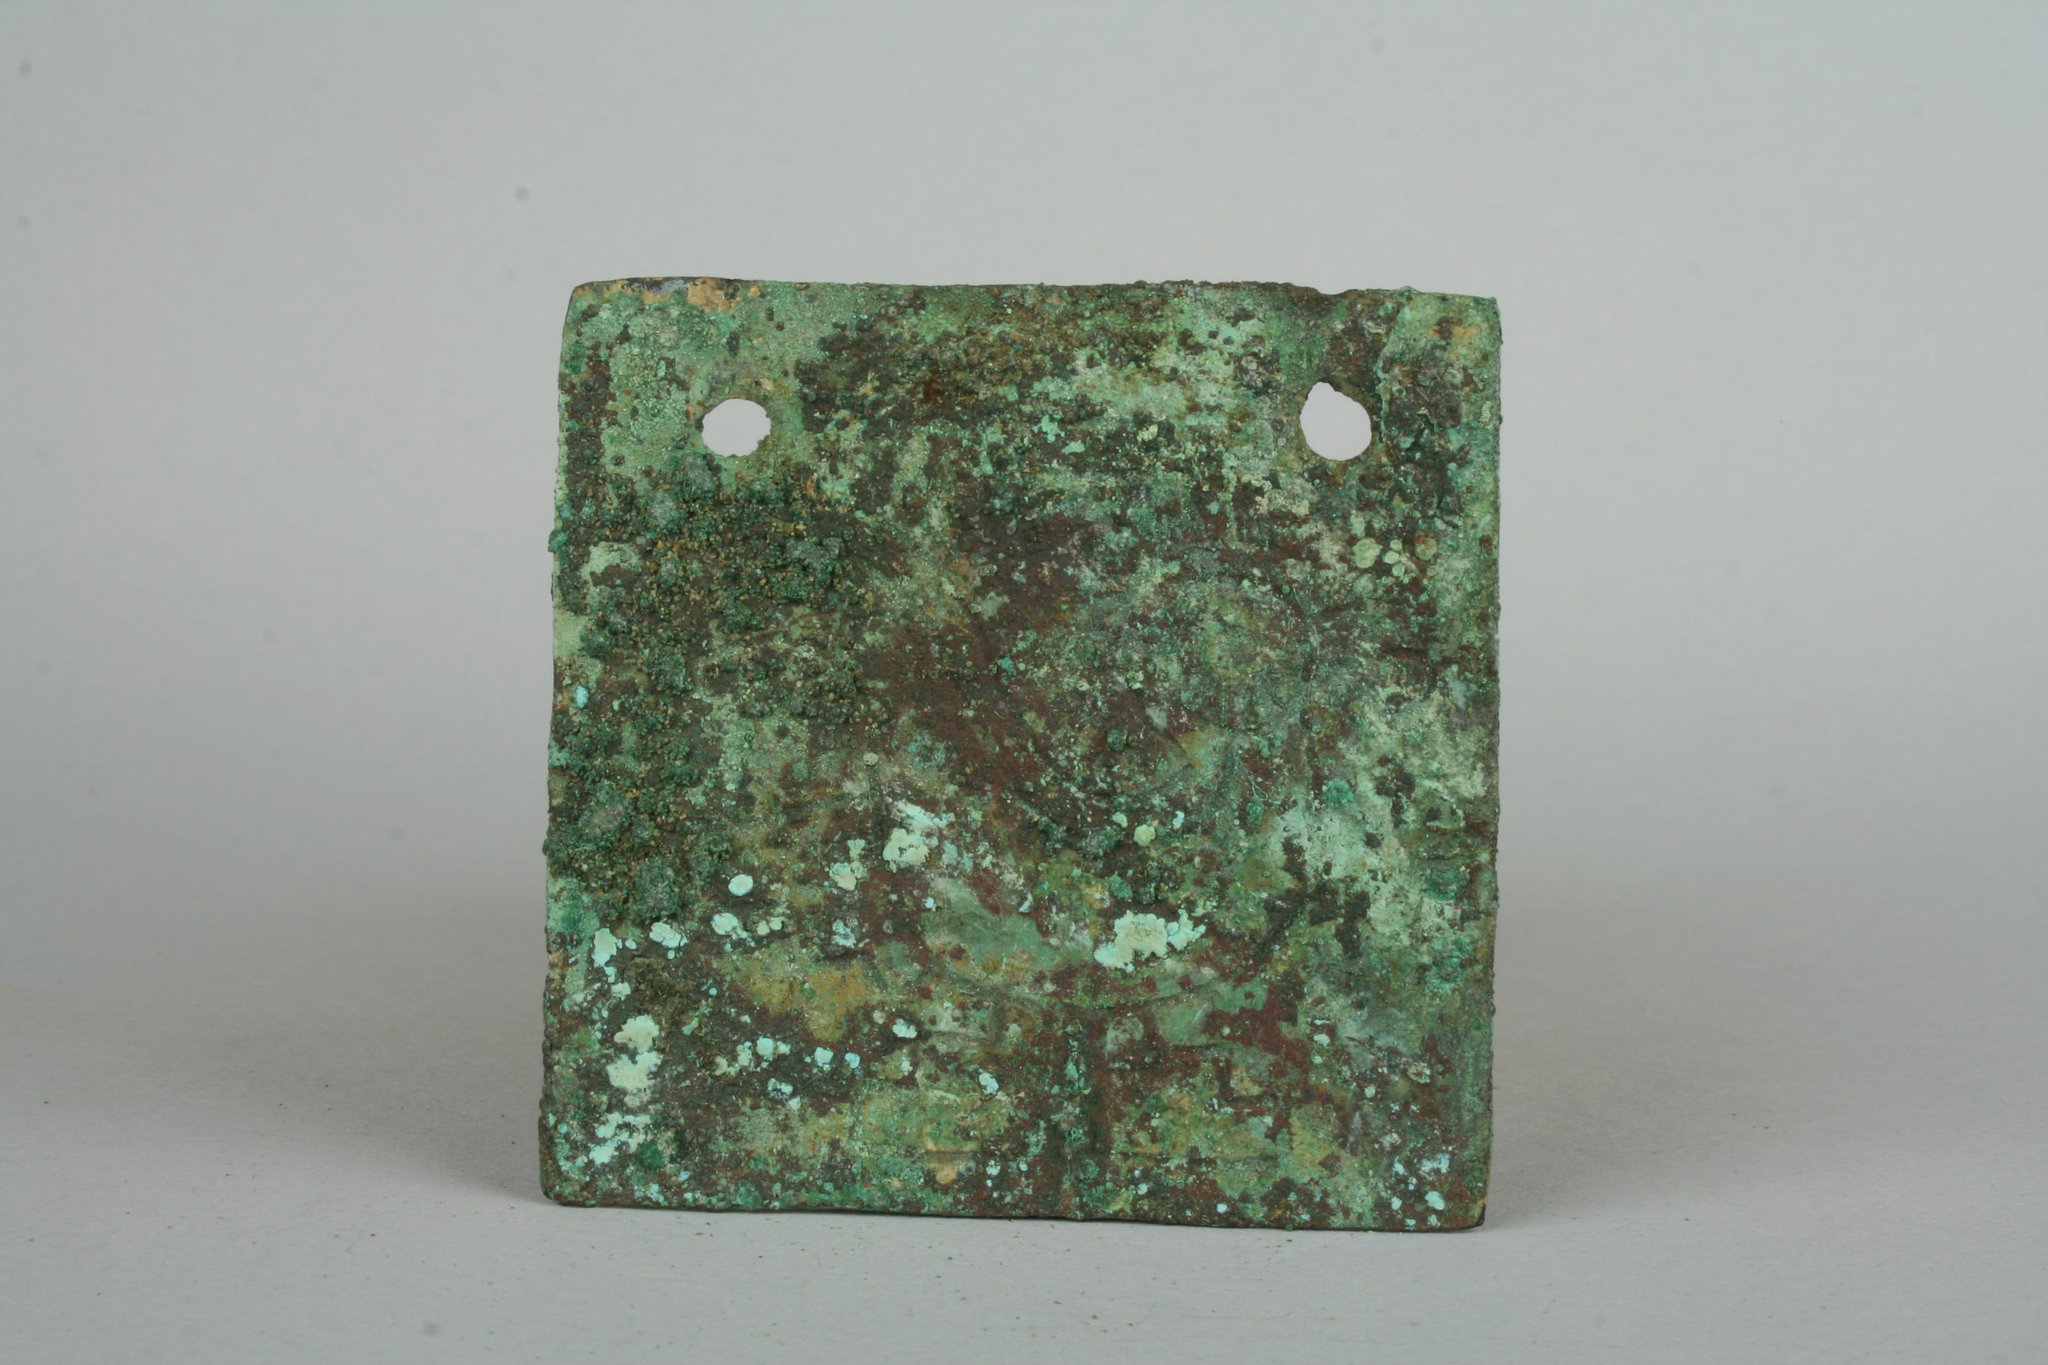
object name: ornament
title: Bird Plaque Ornament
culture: vicús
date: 300 BCE-200 CE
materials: copper, gilt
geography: peru